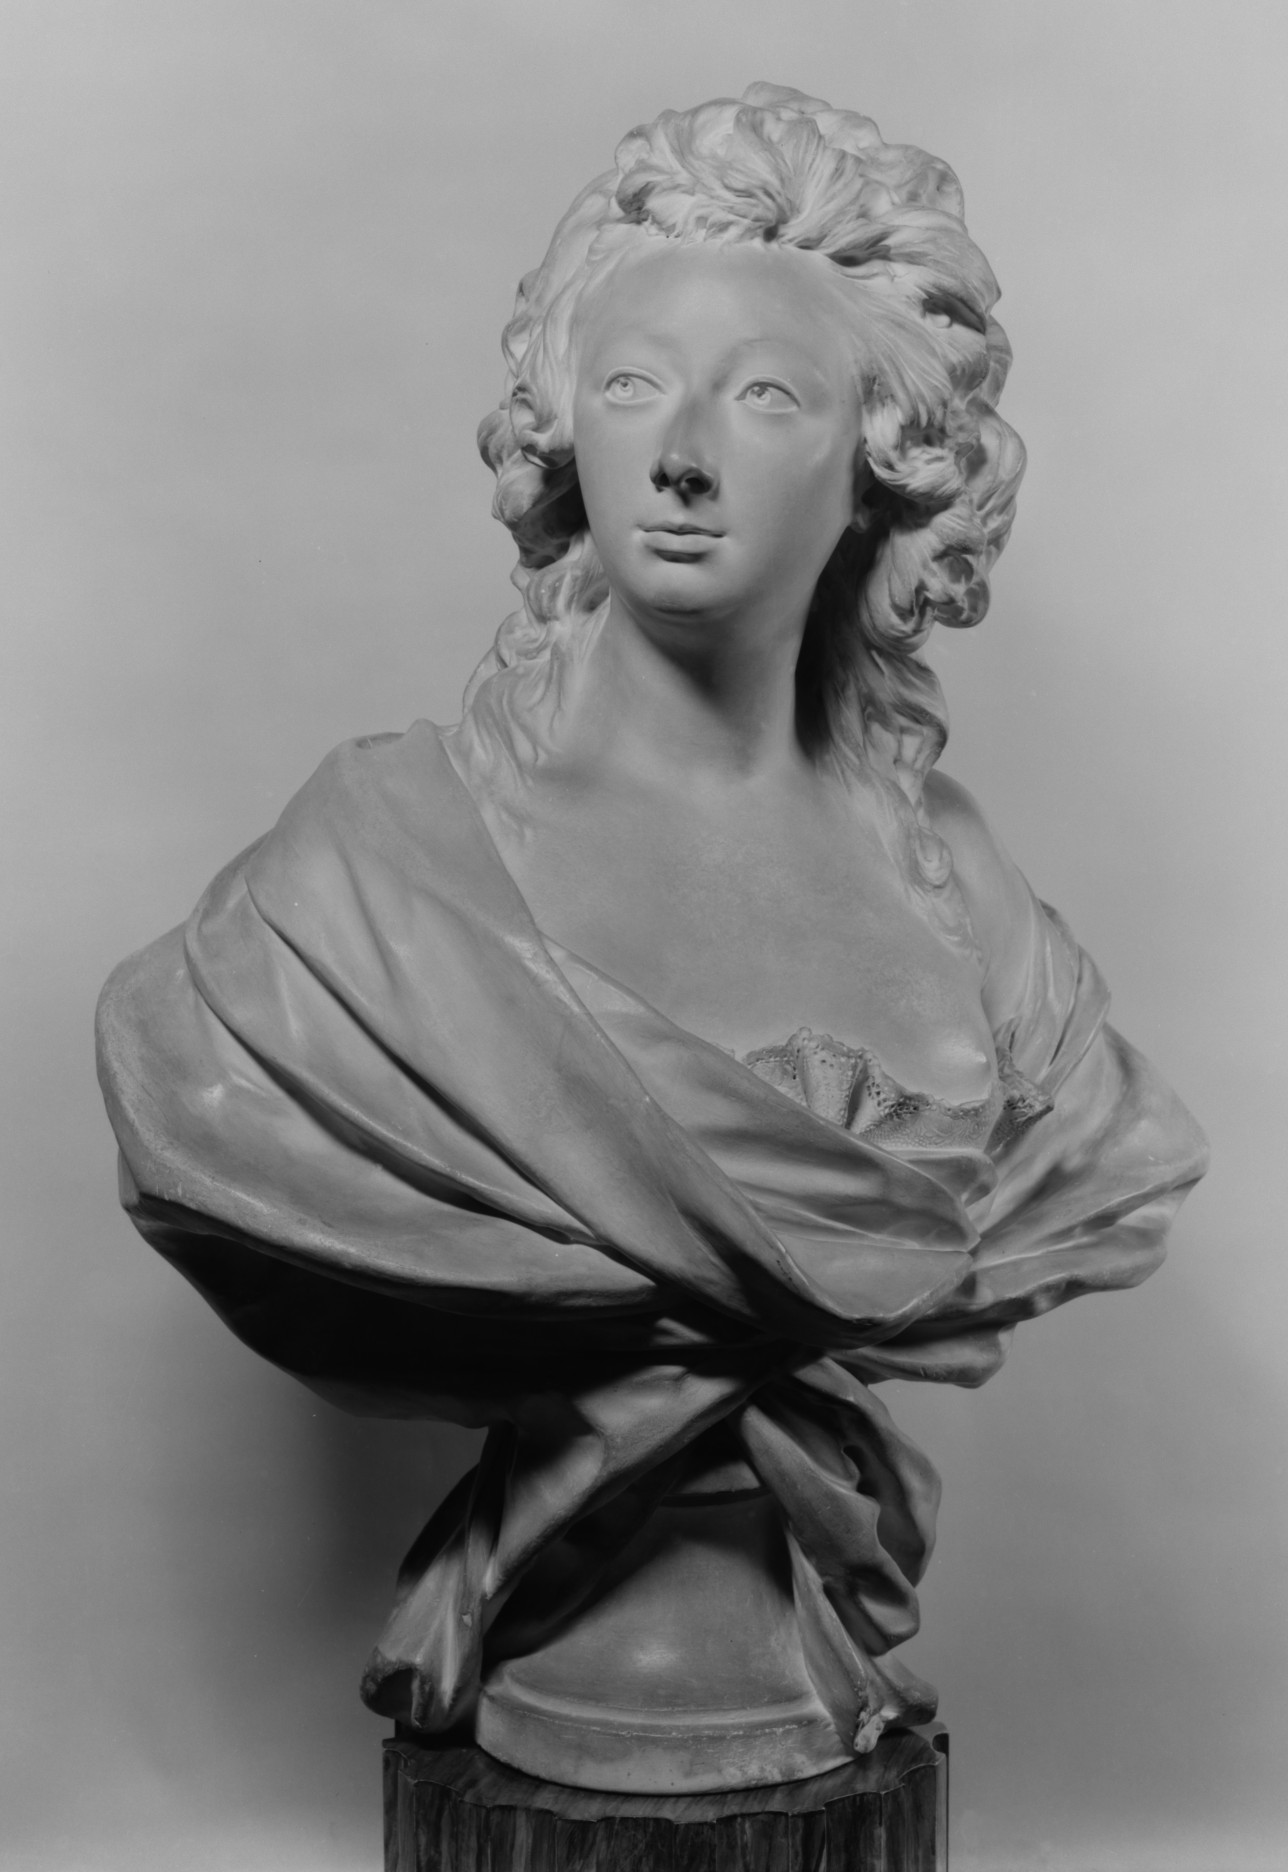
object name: bust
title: Woman, sometimes identified as the Princesse de Lamballe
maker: jean antoine houdon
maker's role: artist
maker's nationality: french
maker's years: 1741-1828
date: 1801-1900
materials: plaster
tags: portraits,women